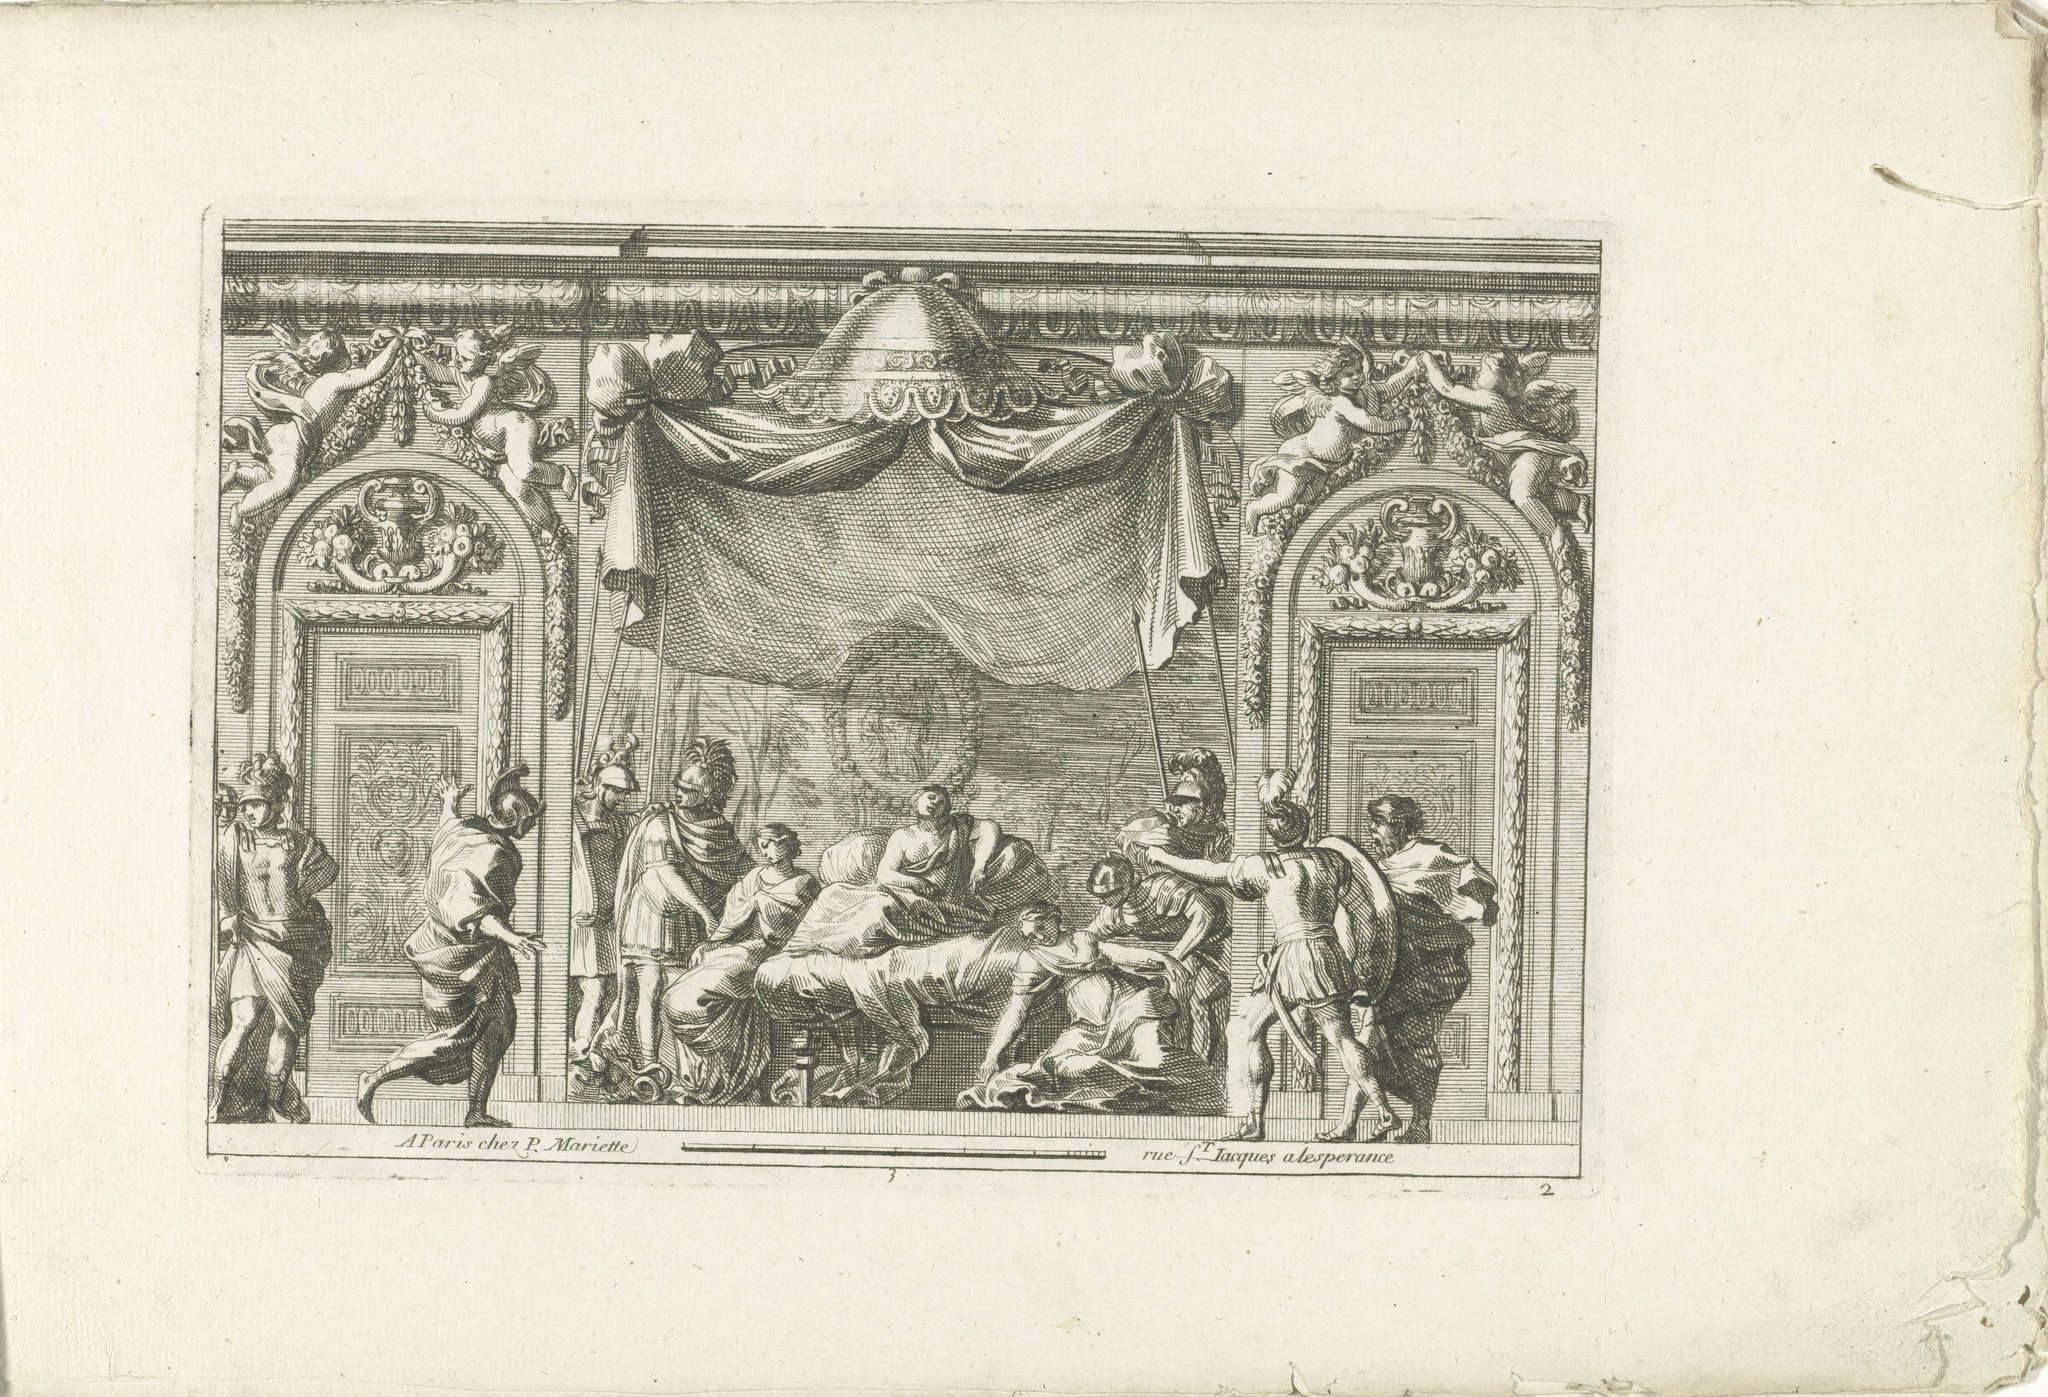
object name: print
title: Alkoof met de dood van Cleopatra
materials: paper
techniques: etching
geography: france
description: Alkoof met Cleopatra liggend op een bed onder een baldakijn. Treurende vrouwen en soldaten omringen haar. Rechtsonder 2 genummerd. Derde editie. De serie bestaat uit een titelblad en vijf bladen, genummerd midden onder 1-5 en rechtsonder 1-4, 6.